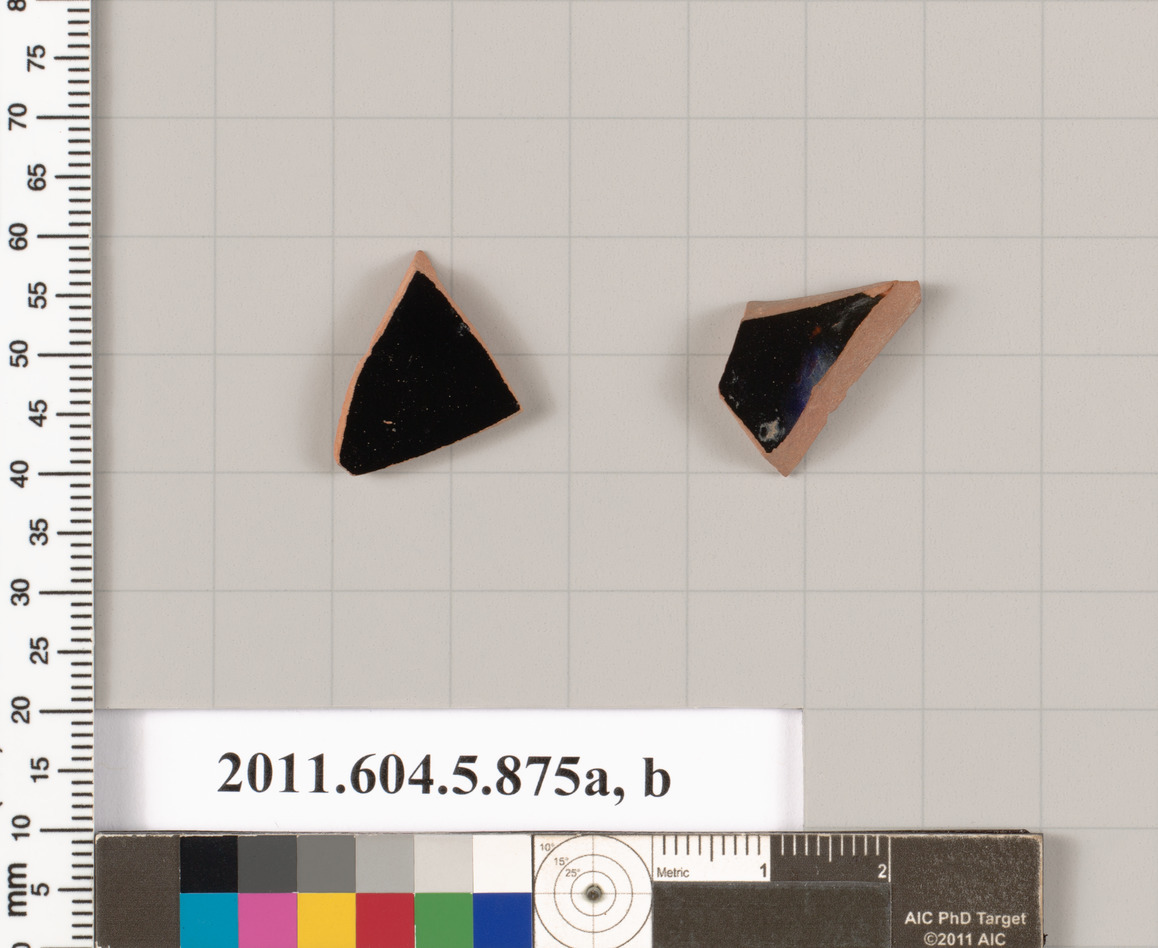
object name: kylix fragment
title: Terracotta fragments of kylikes (drinking cups)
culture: greek, attic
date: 600-401 BCE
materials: terracotta